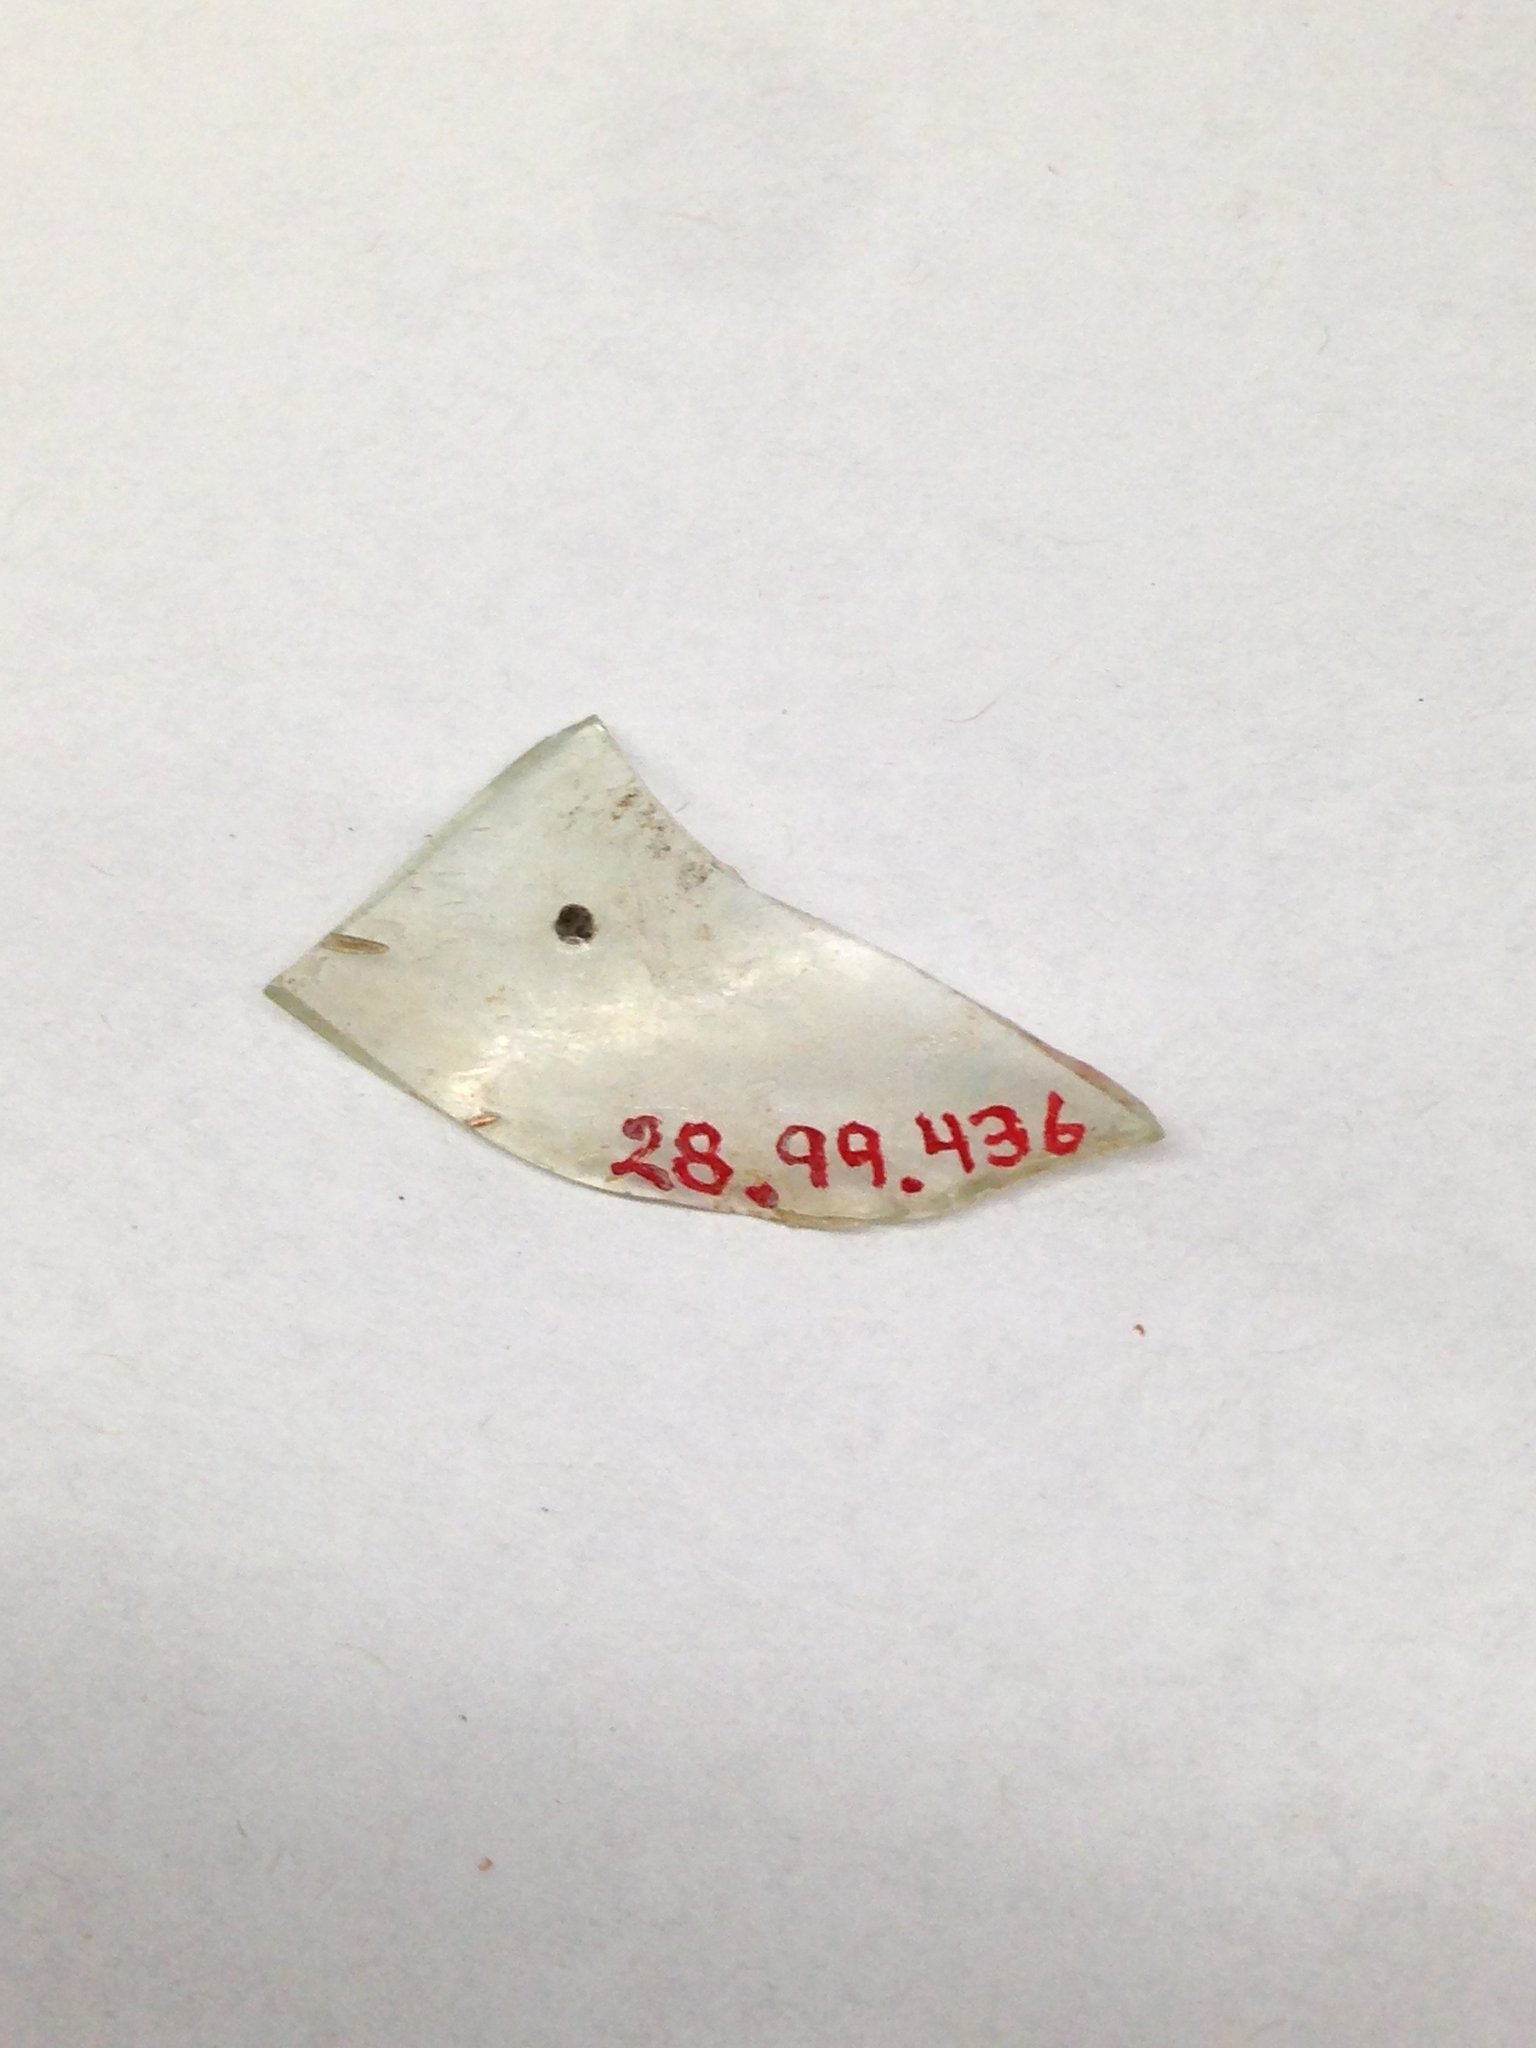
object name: fragment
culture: european or middle eastern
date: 1150-1250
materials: ceramic, glass